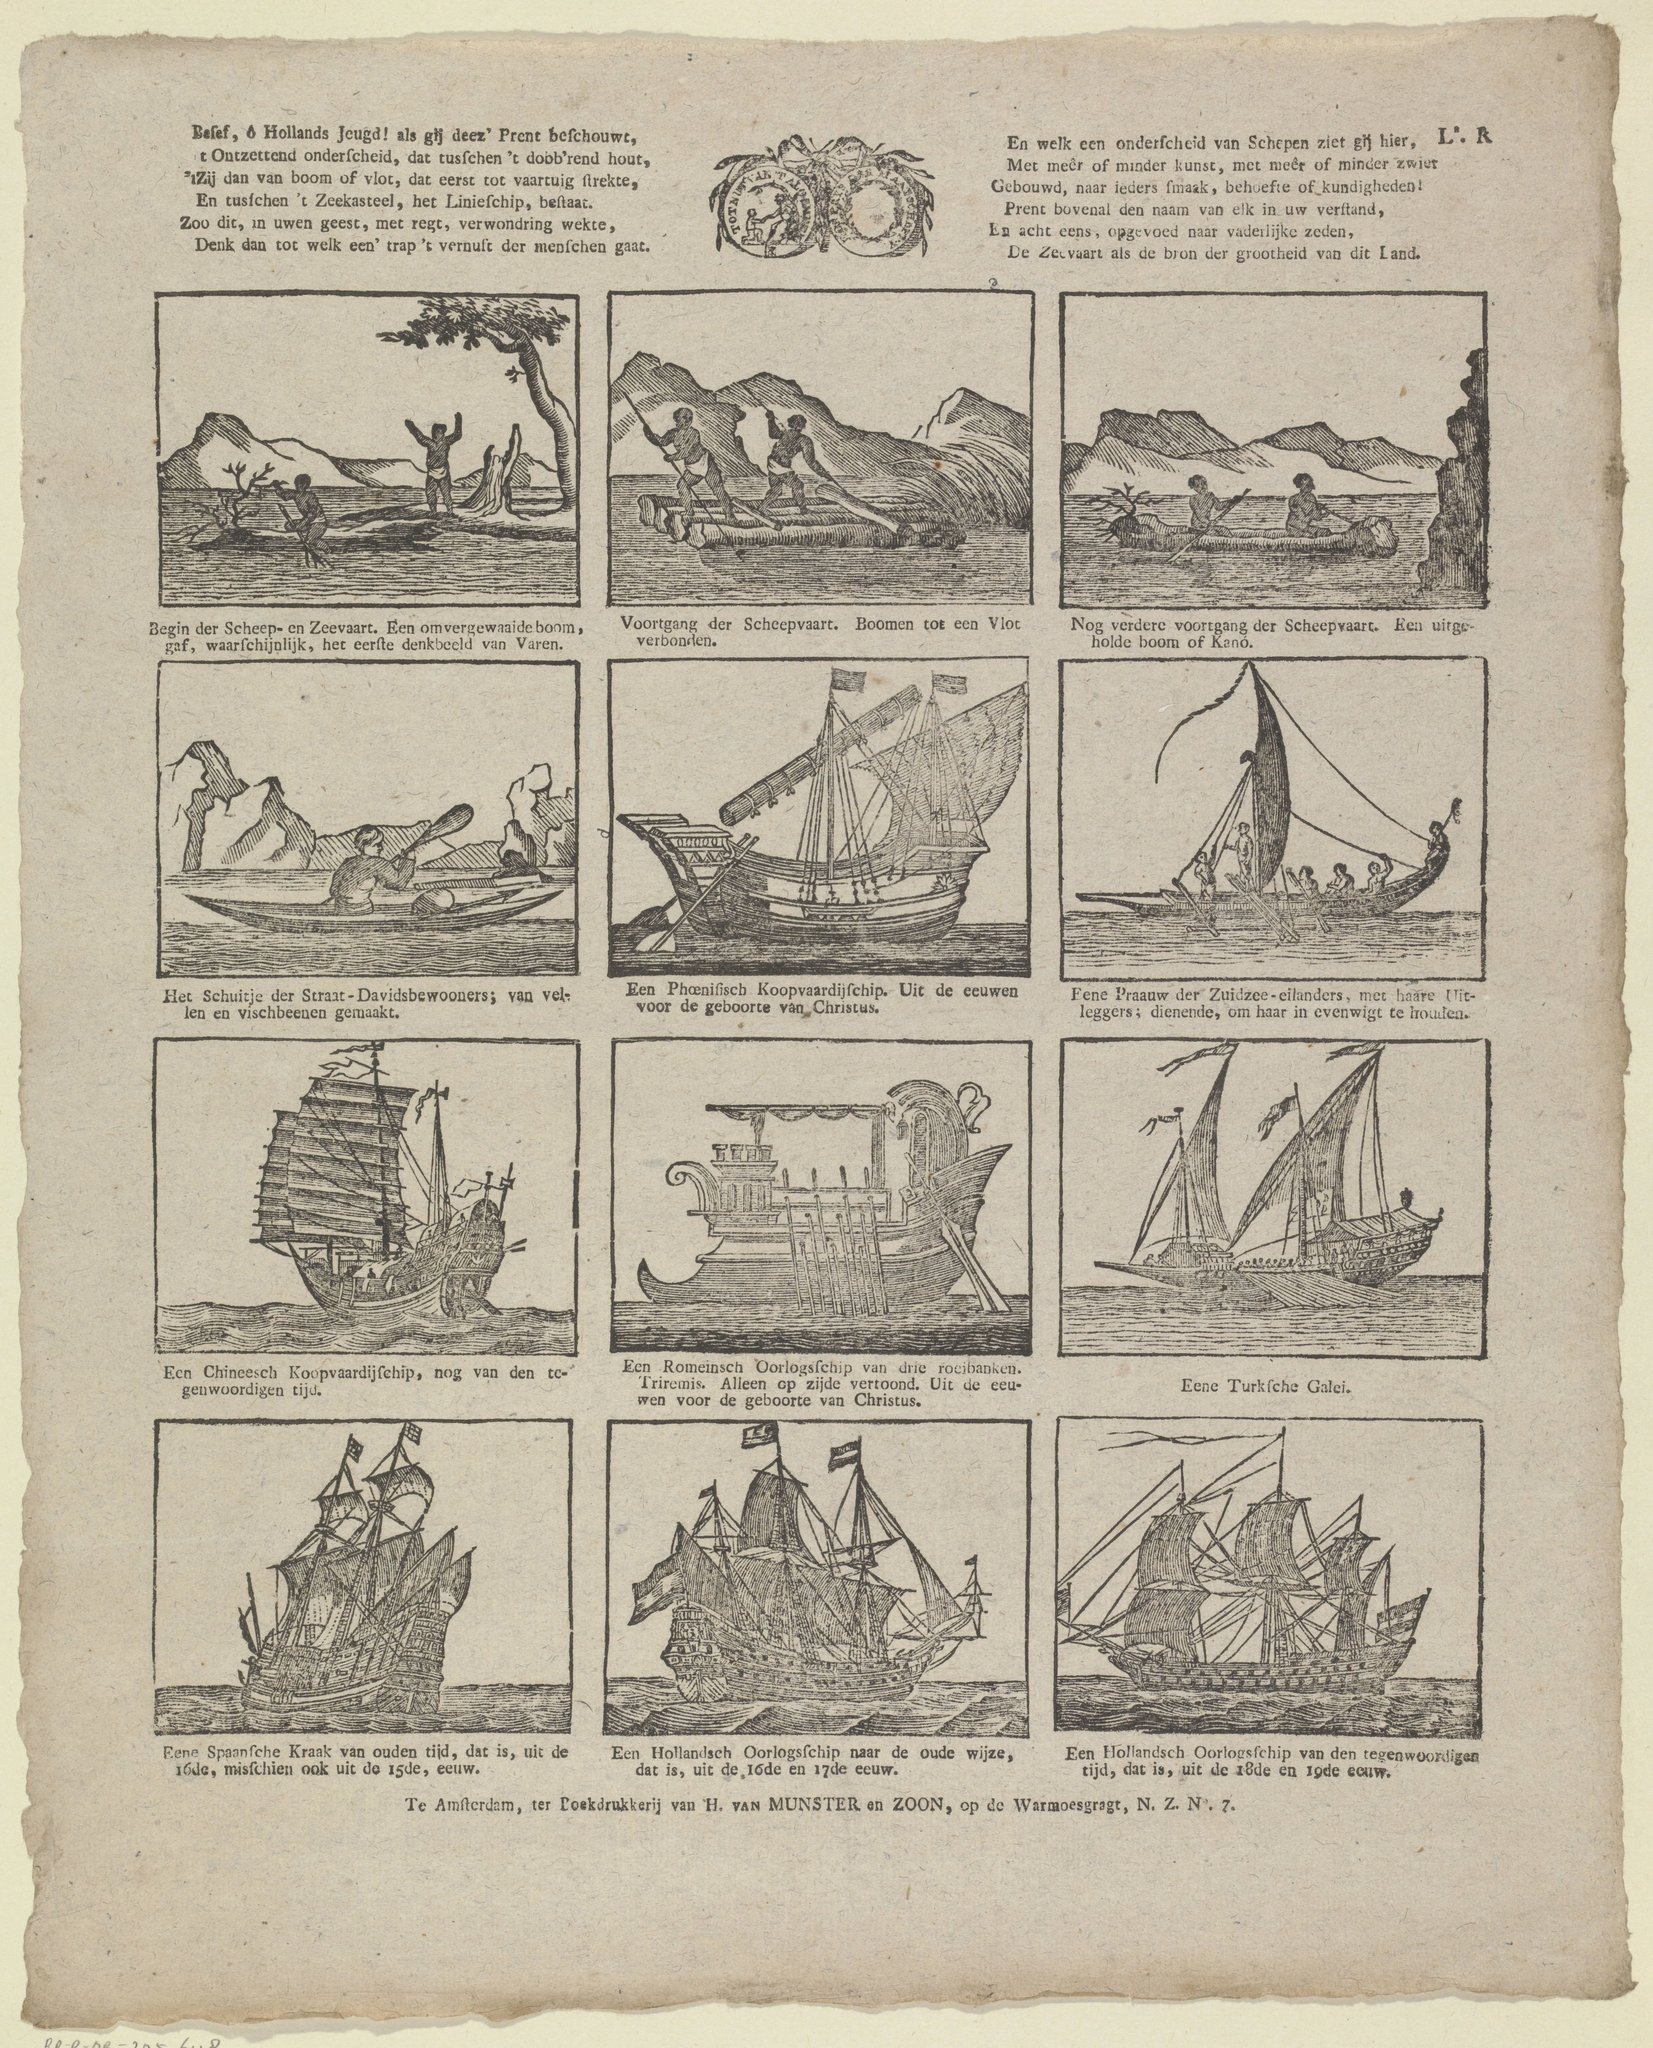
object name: popular print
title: Besef, ô Hollands jeugd! als gij deez' prent beschouwt, / 't Ontzettend onderscheid, dat tusschen 't dobb'rend hout [(...)]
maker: Anonymous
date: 1811-1829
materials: paper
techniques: letterpress printing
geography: netherlands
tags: traffic on the water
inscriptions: collector's mark: Lugt 2760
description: Blad met 12 voorstellingen van vaartuigen, zoals een simpele boomstamkano en een Hollands oorlogsschip. Bovenaan twee zesregelige verzen. Midden boven het zegel van de Maatschappij tot Nut van 't Algemeen. Onder elke afbeelding een tweeregelig onderschrift. Genummerd rechtsboven: L.R.